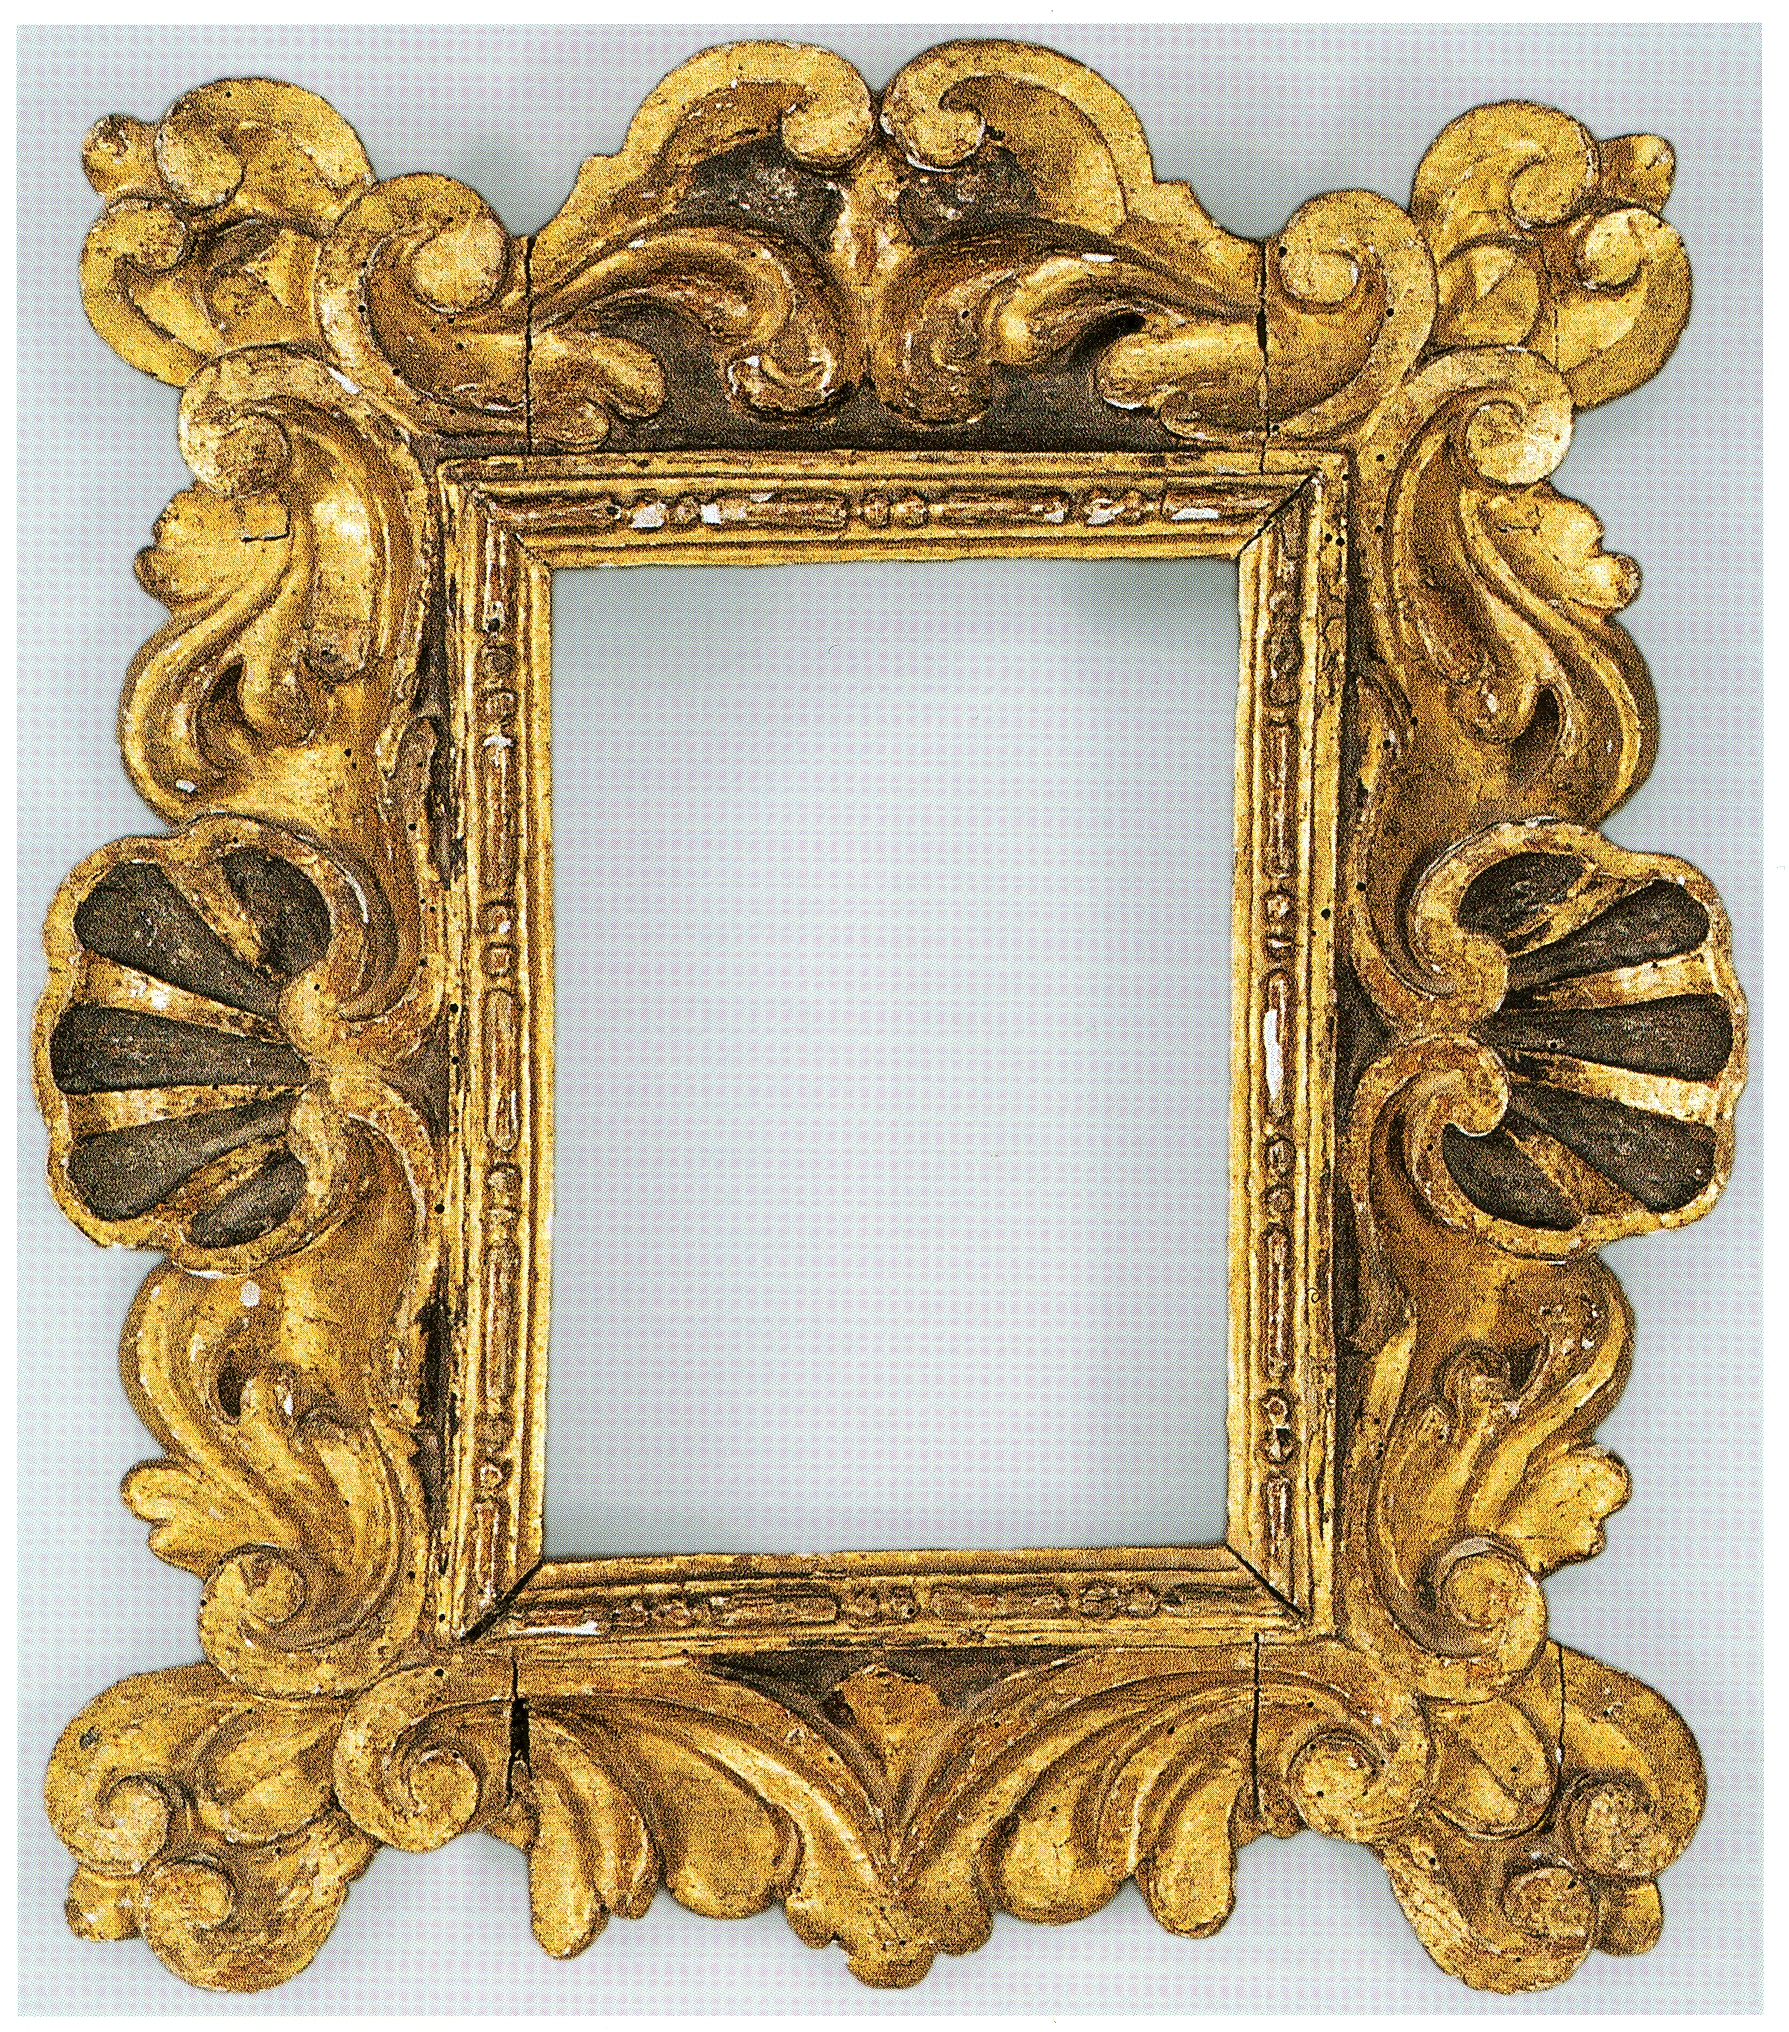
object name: frame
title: Palatina-style frame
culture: italian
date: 1701-1733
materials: wood